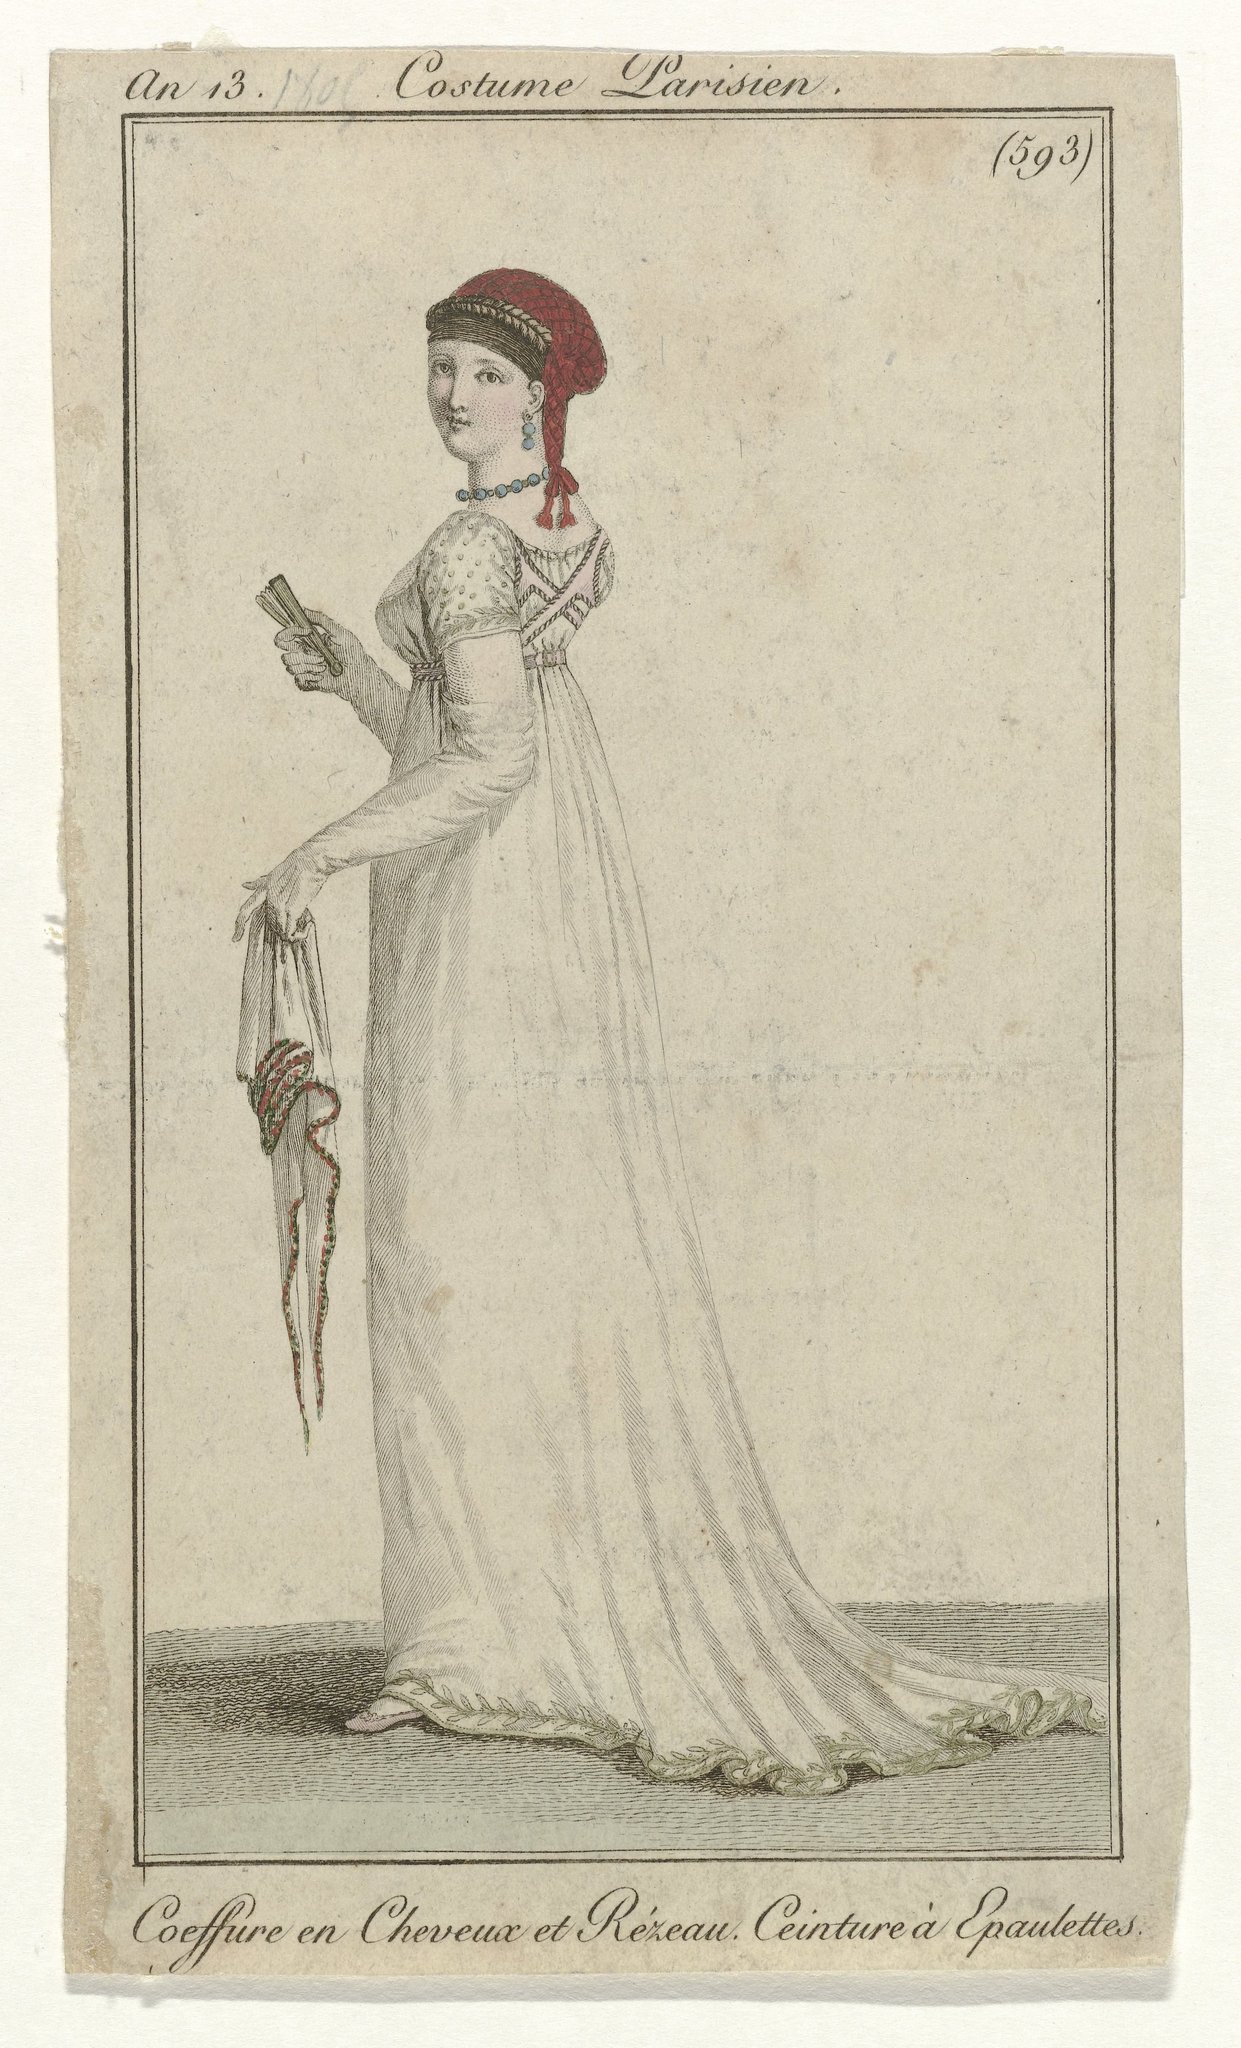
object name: fashion print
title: Journal des Dames et des Modes, Costume Parisien, 1 novembre 1804, An 13, (593): Coeffure en Cheveux (...)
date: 1804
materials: paper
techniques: engraving, hand coloring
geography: paris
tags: ear-rings (+ women's clothes), handkerchief (+ women's clothes), gloves, mittens (long gloves) (+ women's clothes), head-gear (+ women's clothes), styles of hairdress - aa - ~ women, fashion plates, dress, gown (+ women's clothes), fan (+ women's clothes), necklace (+ women's clothes), belt, girdle, waistband (+ women's clothes)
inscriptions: caption: ‘Coeffure en cheveux et Rézeau. Ceinture à Epaulettes.’, title: ‘Costume Parisien.’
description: Vrouw, op de rug gezien, met een 'coeffure' met haarnet. Zij draagt een japon met gestippelde korte mouwen en sleep afgezet met guirlande. Ceintuur met schouderbanden, op de rug gekruist, afgezet met gestreepte bies. Verdere accessoires: oorbel in het linkeroor, collier, lange handschoenen, waaier, zakdoek, platte schoen. De prent maakt deel uit van het modetijdschrift Journal des Dames et des Modes, uitgegeven door Pierre de la Mésangère, Parijs, 1797-1839.